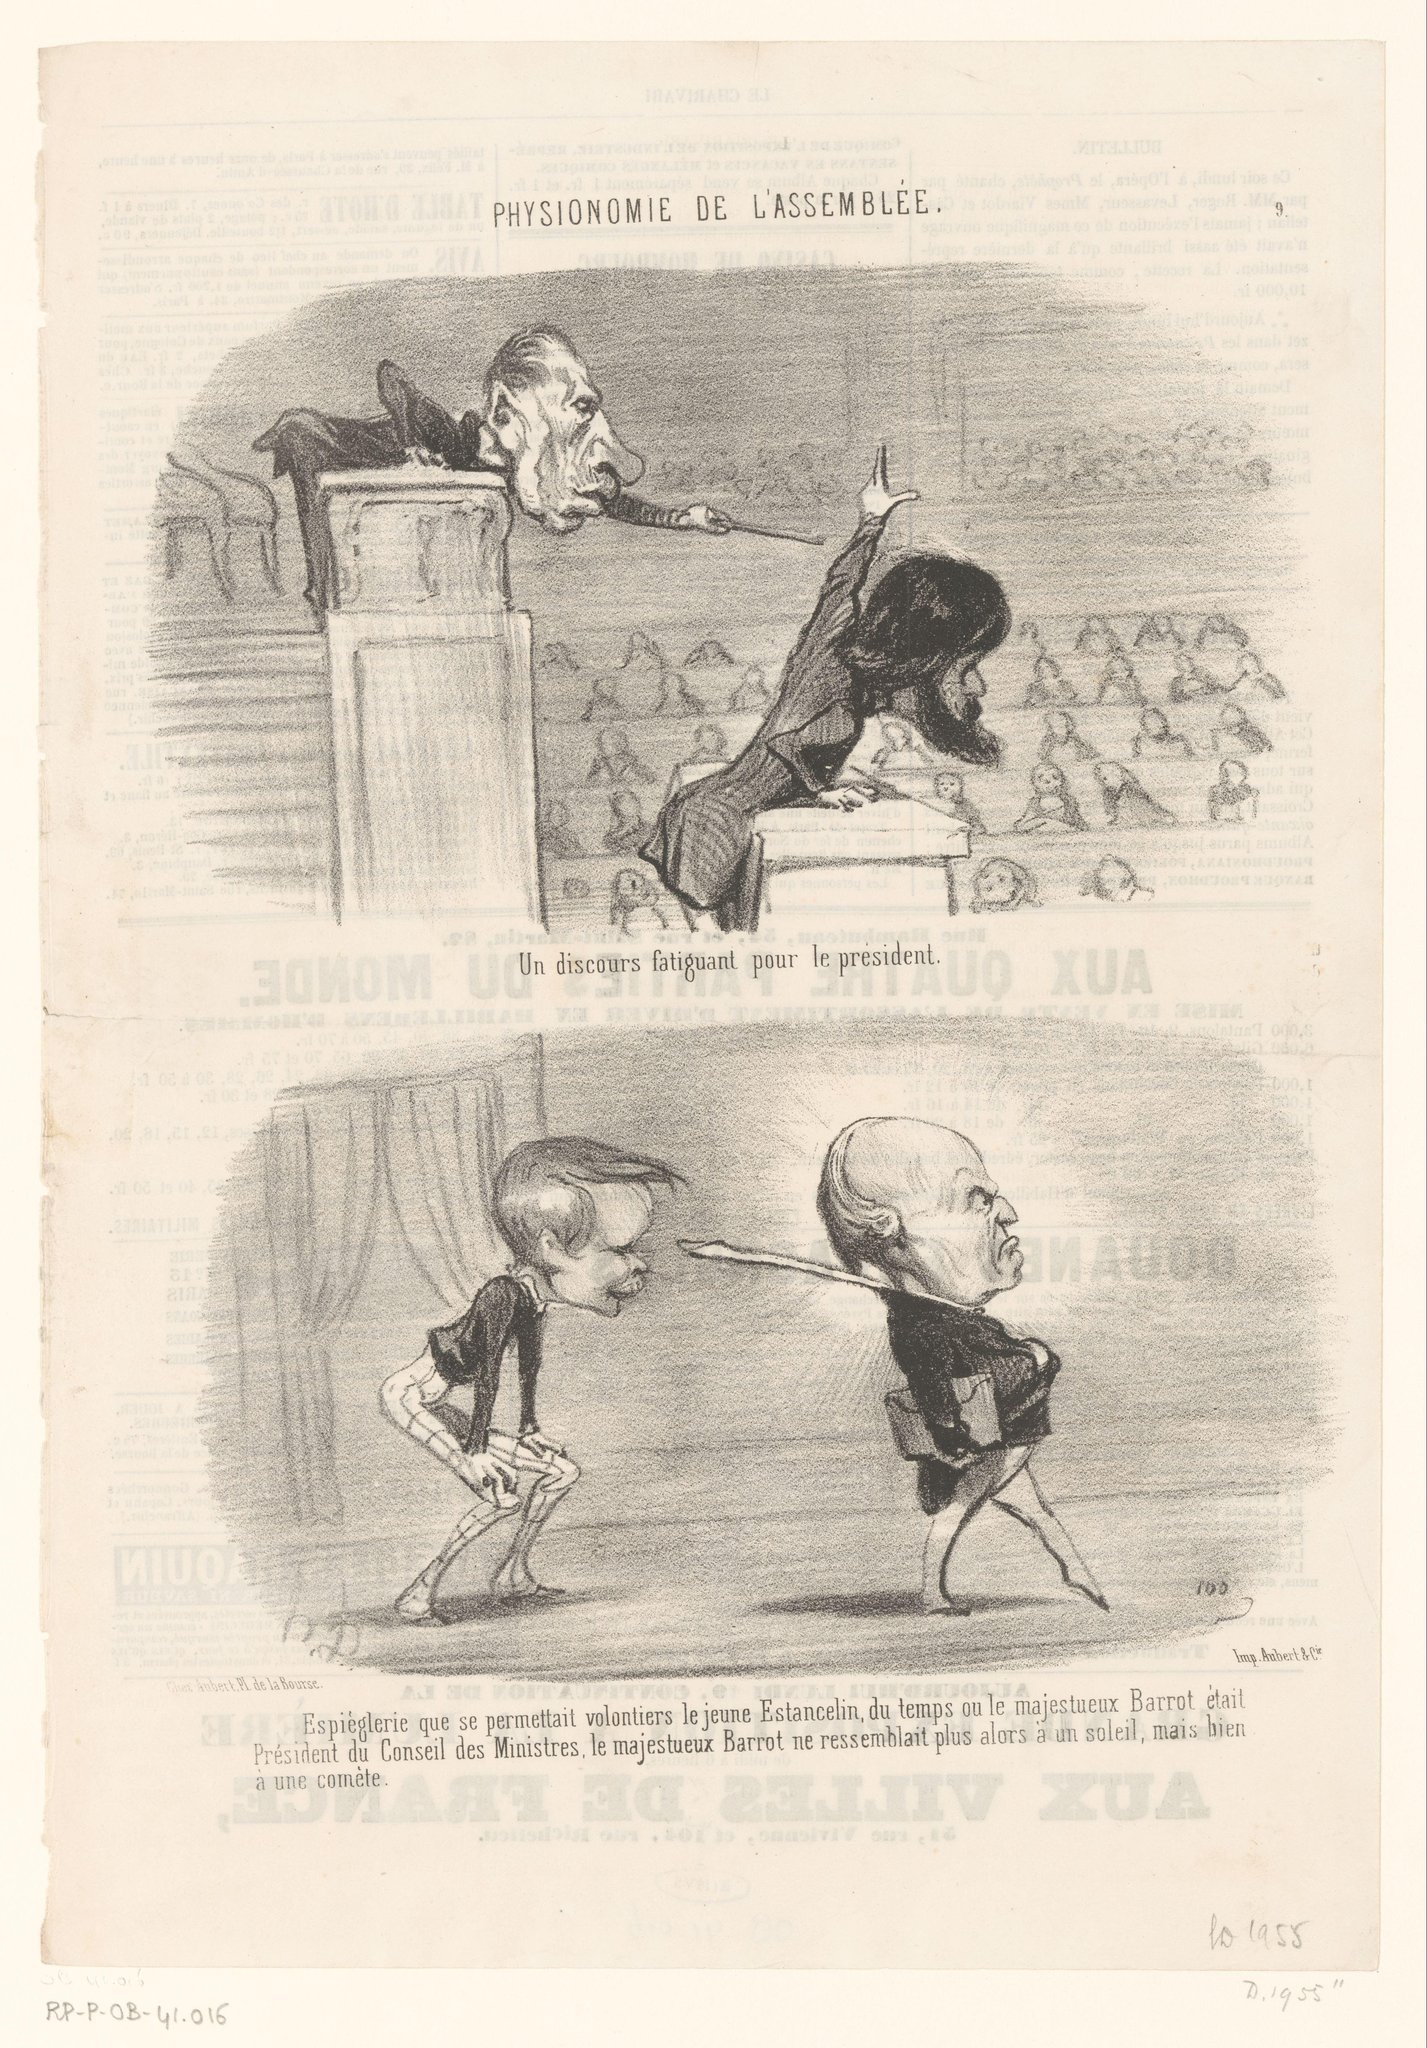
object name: cartoon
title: Physionomie de l'Assemblée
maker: honoré daumier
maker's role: draughtsman, painter, print maker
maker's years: 1808-1879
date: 1849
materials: paper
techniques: lithograph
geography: paris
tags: caricatures (human types), lower house, parliament, chamber, political caricatures and satires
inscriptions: collector's mark: Lugt 2228a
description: Prent gebruikt voor: Le Charivari, 19 november 1849.